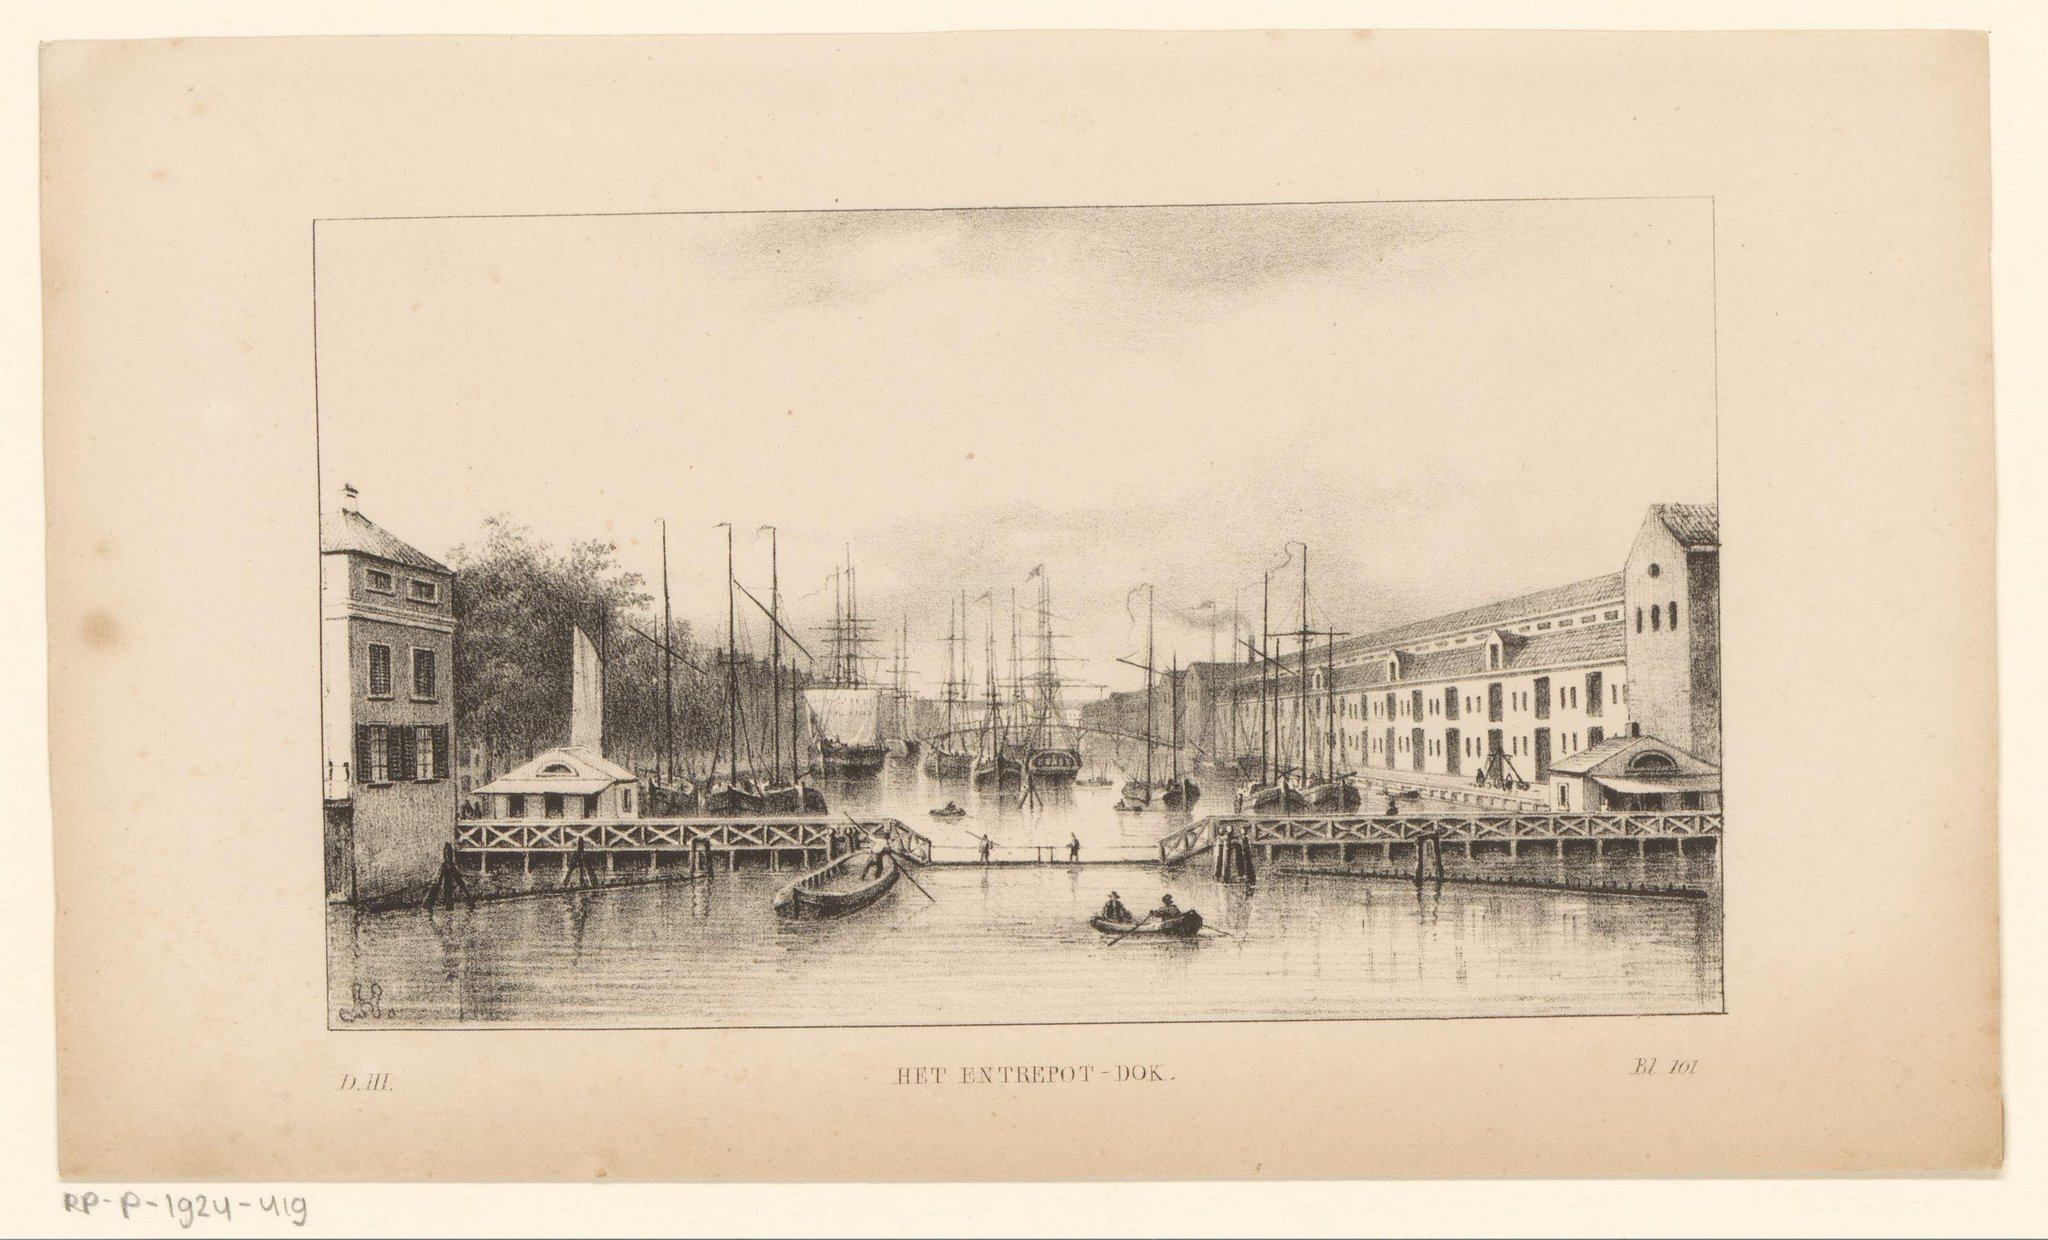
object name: print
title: Het Entrepôt-dok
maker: johannes hilverdink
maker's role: draughtsman, painter, print maker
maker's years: 1813-1902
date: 1844-1848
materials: paper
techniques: lithograph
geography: amsterdam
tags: warehouse (~ harbour)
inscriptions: collector's mark: Lugt 2233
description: Prent uit: Vijver, C. van der. Geschiedkundige beschrijving der stad Amsterdam. Amsterdam: Diederichs, Gebroeders, 1844-1848.